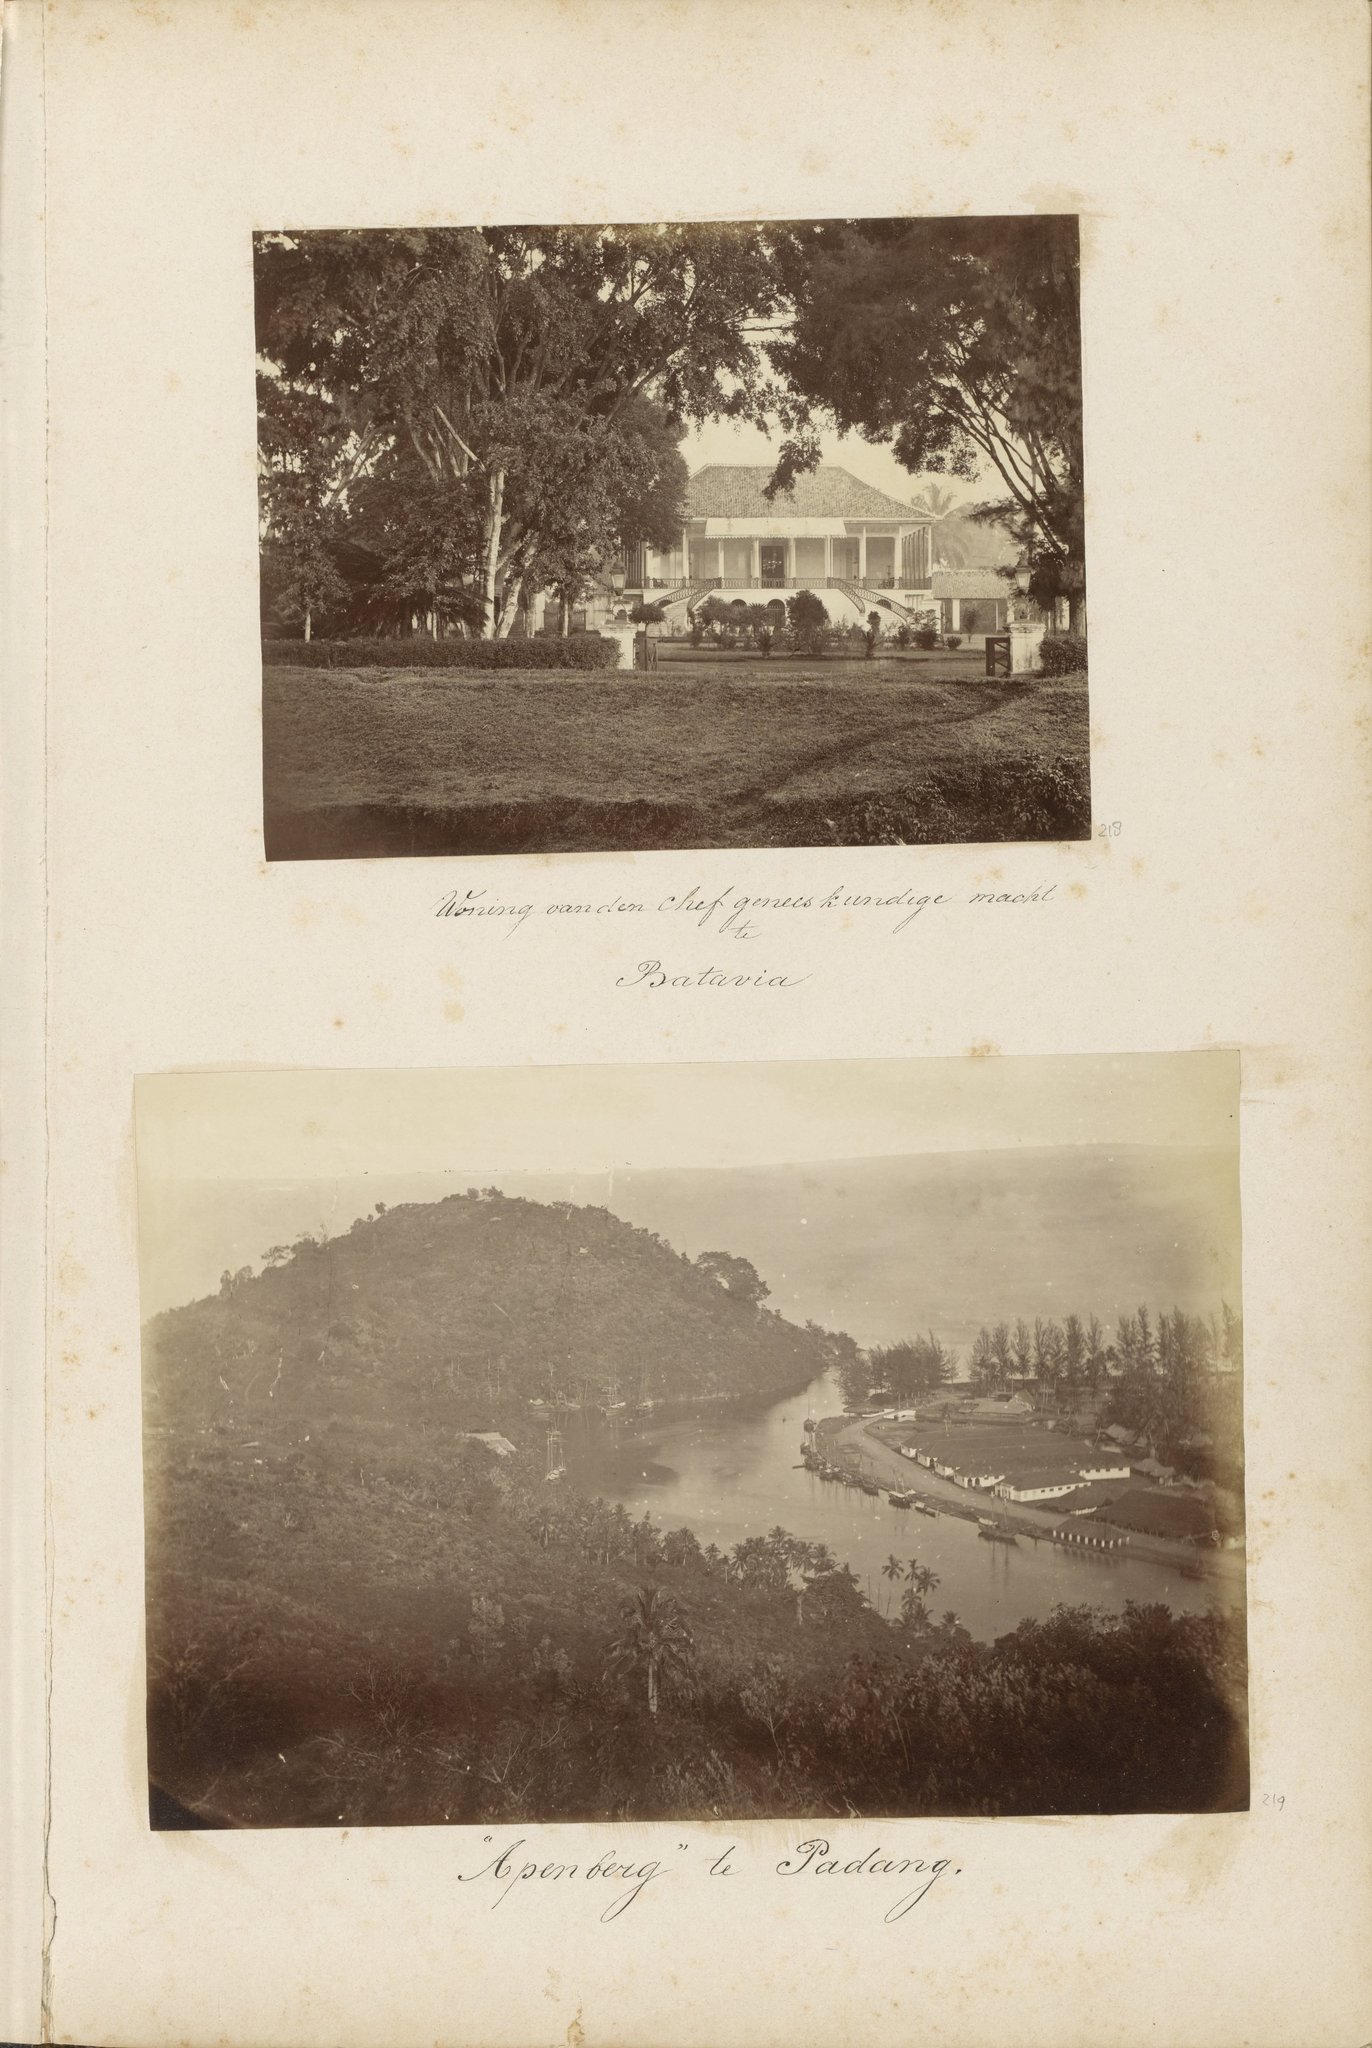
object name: photograph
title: Gezicht op de Apenberg, de riviermond en gebouwen in Padang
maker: Anonymous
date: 1870-1880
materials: paper, photographic support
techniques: albumen print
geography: padang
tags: river, harbour (+ view ~ vehicle, ship, etc.), mountains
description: Onderdeel van Fotoalbum van Robert Daniel Crommelin (1841-1907).